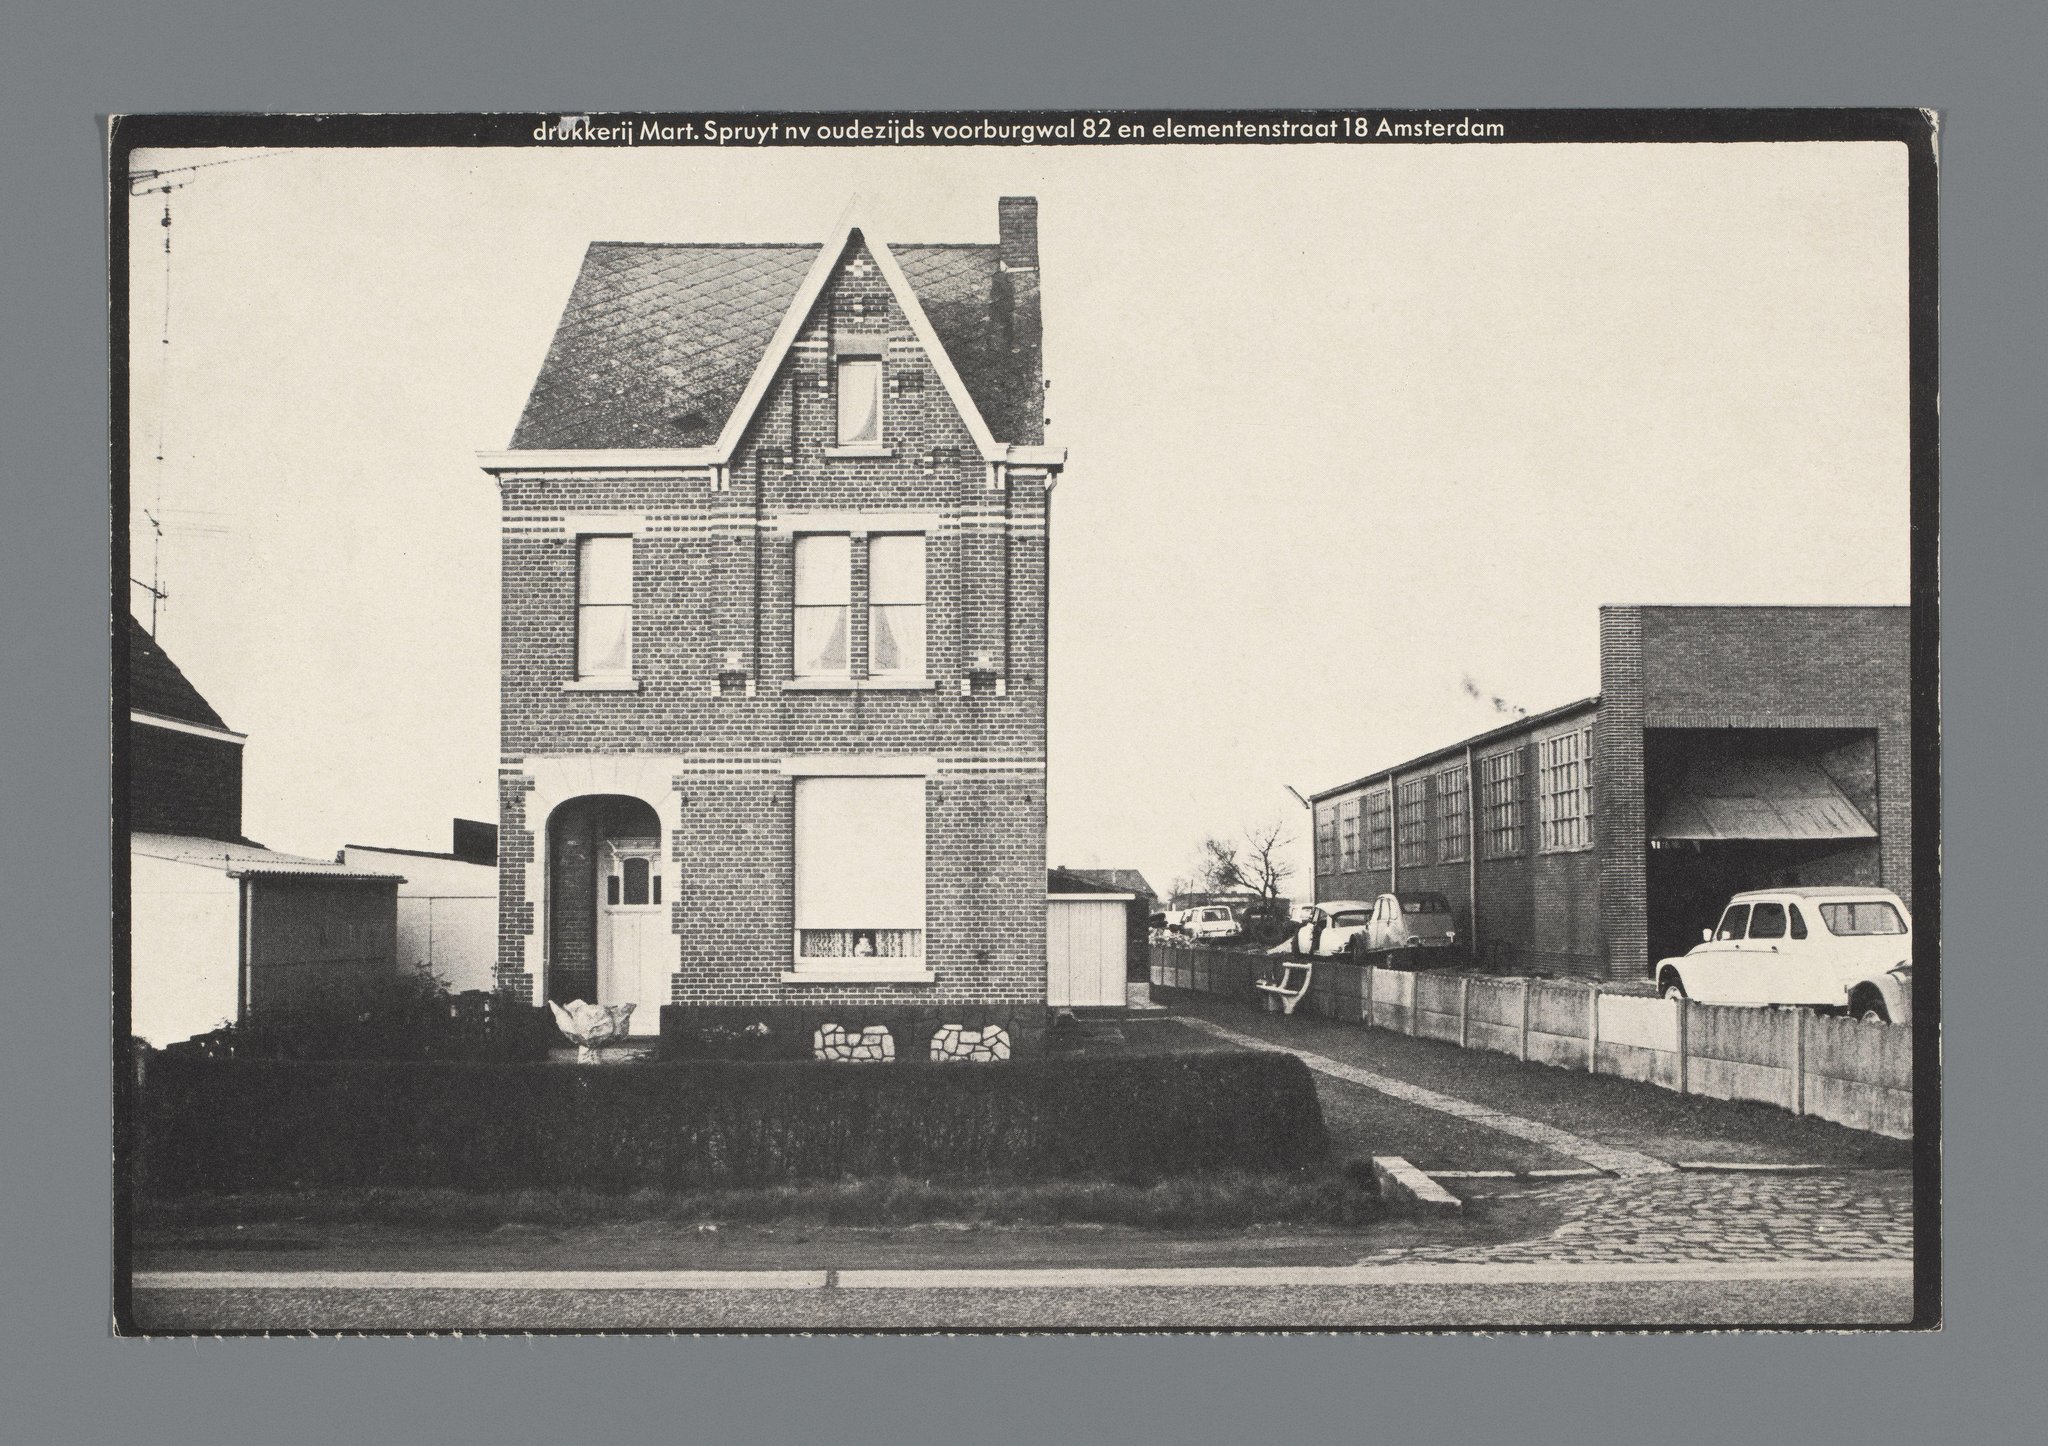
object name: photograph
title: België. Huizen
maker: Anonymous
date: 1900-1950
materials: paper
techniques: offset printed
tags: belgium